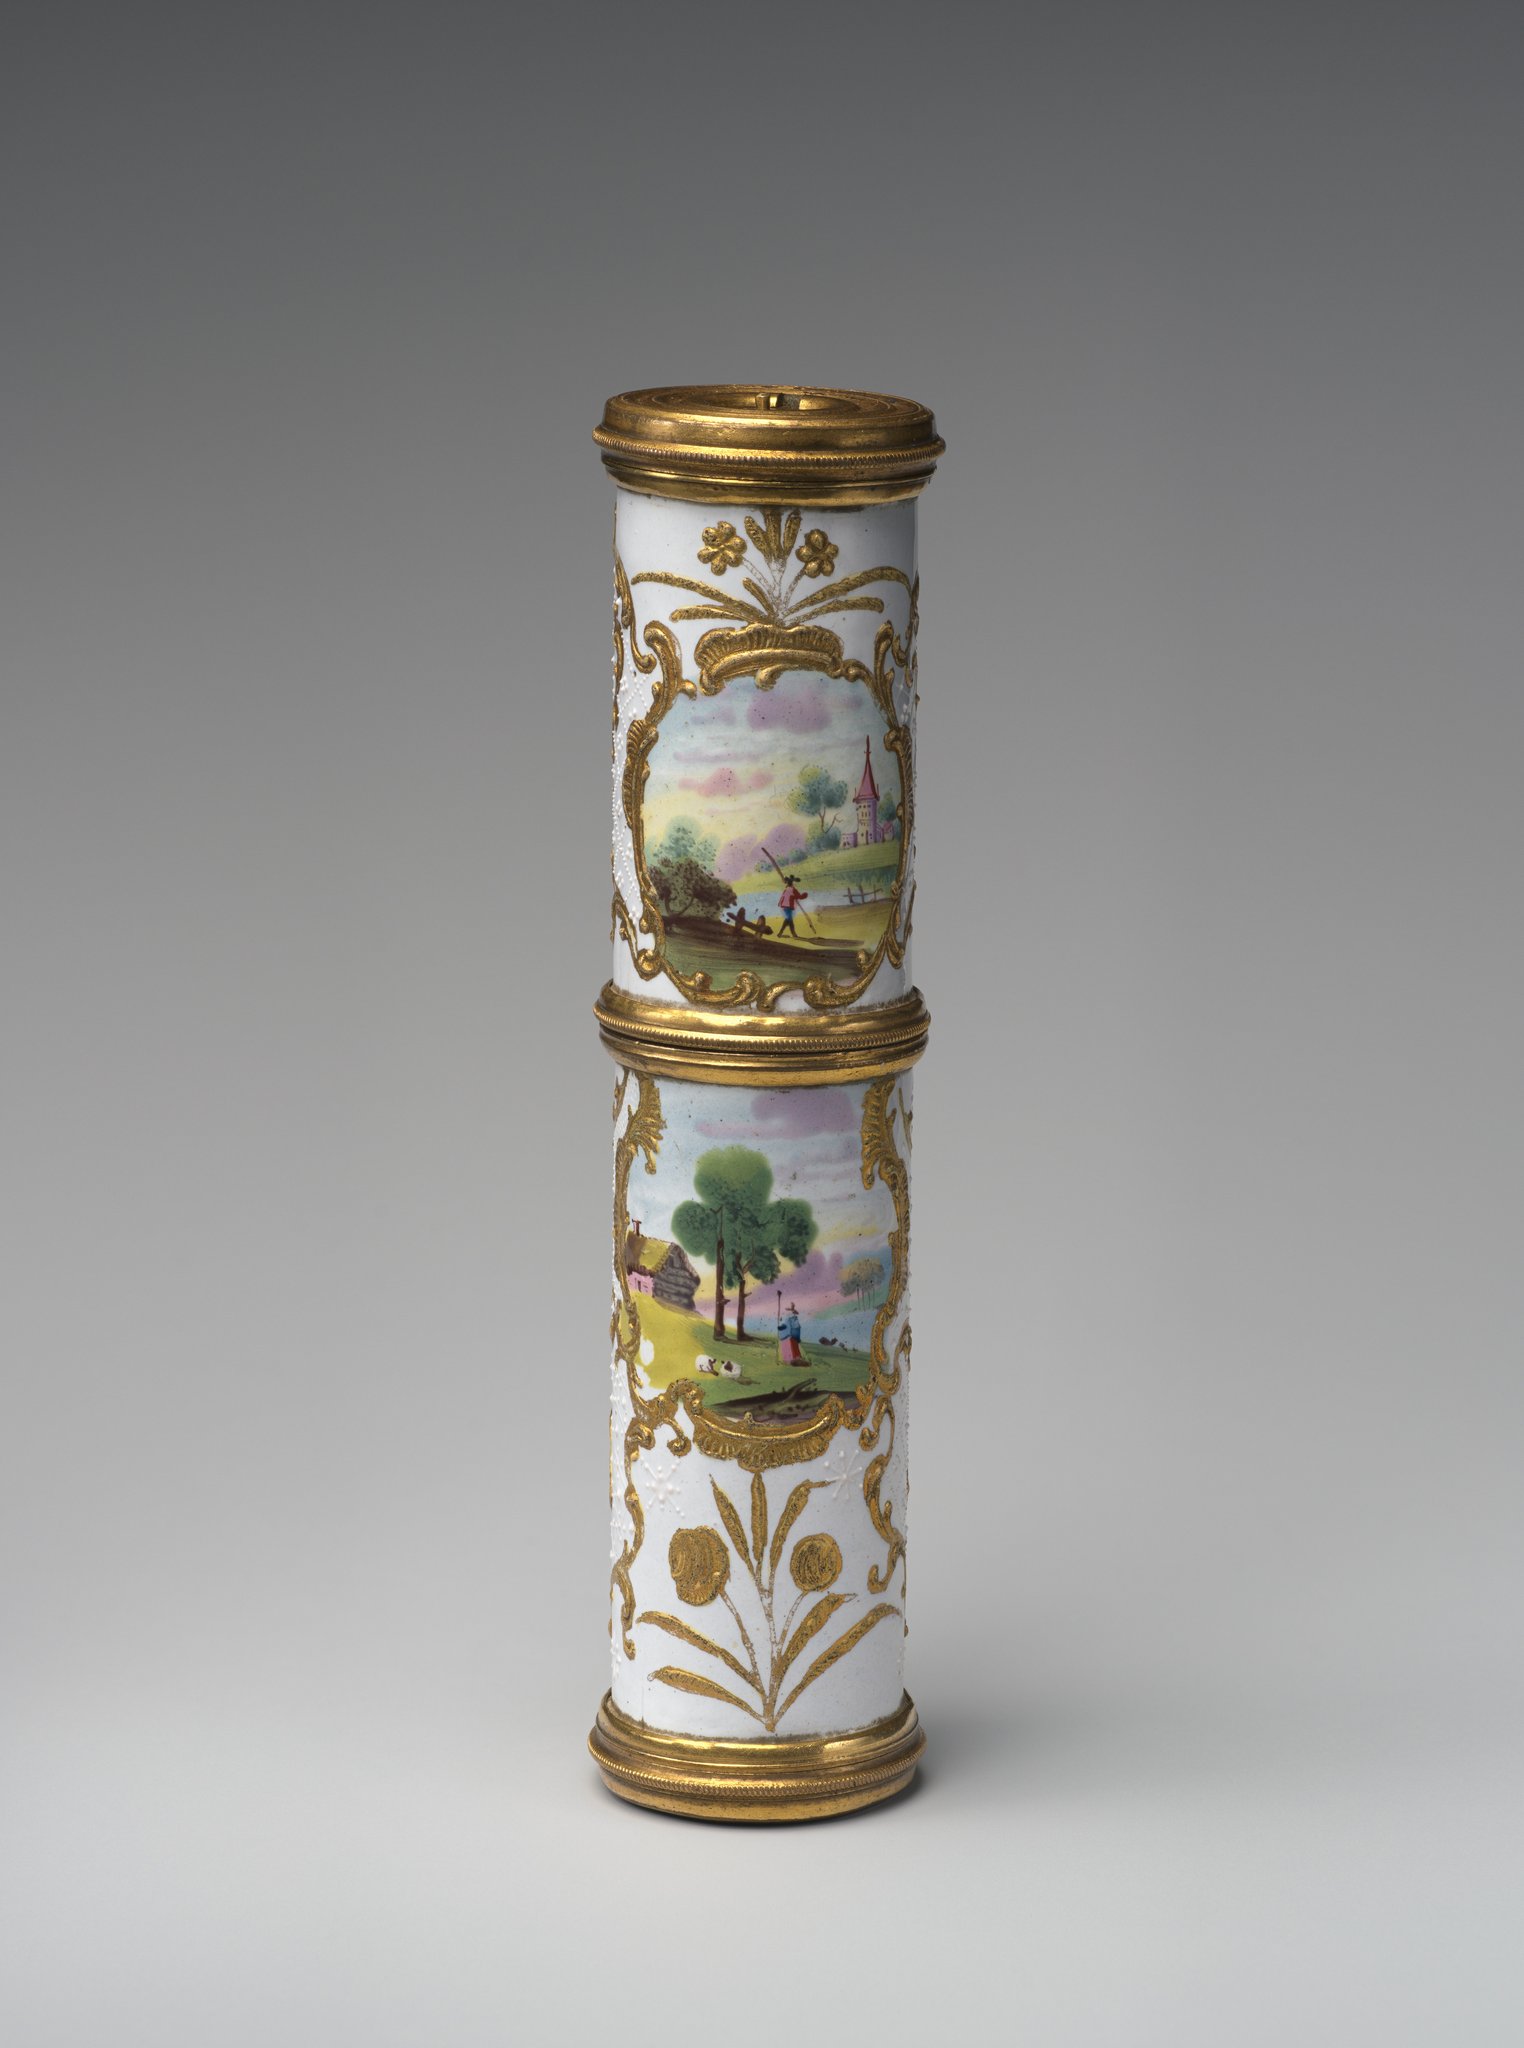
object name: nécessaire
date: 1765-1770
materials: copper, enamel